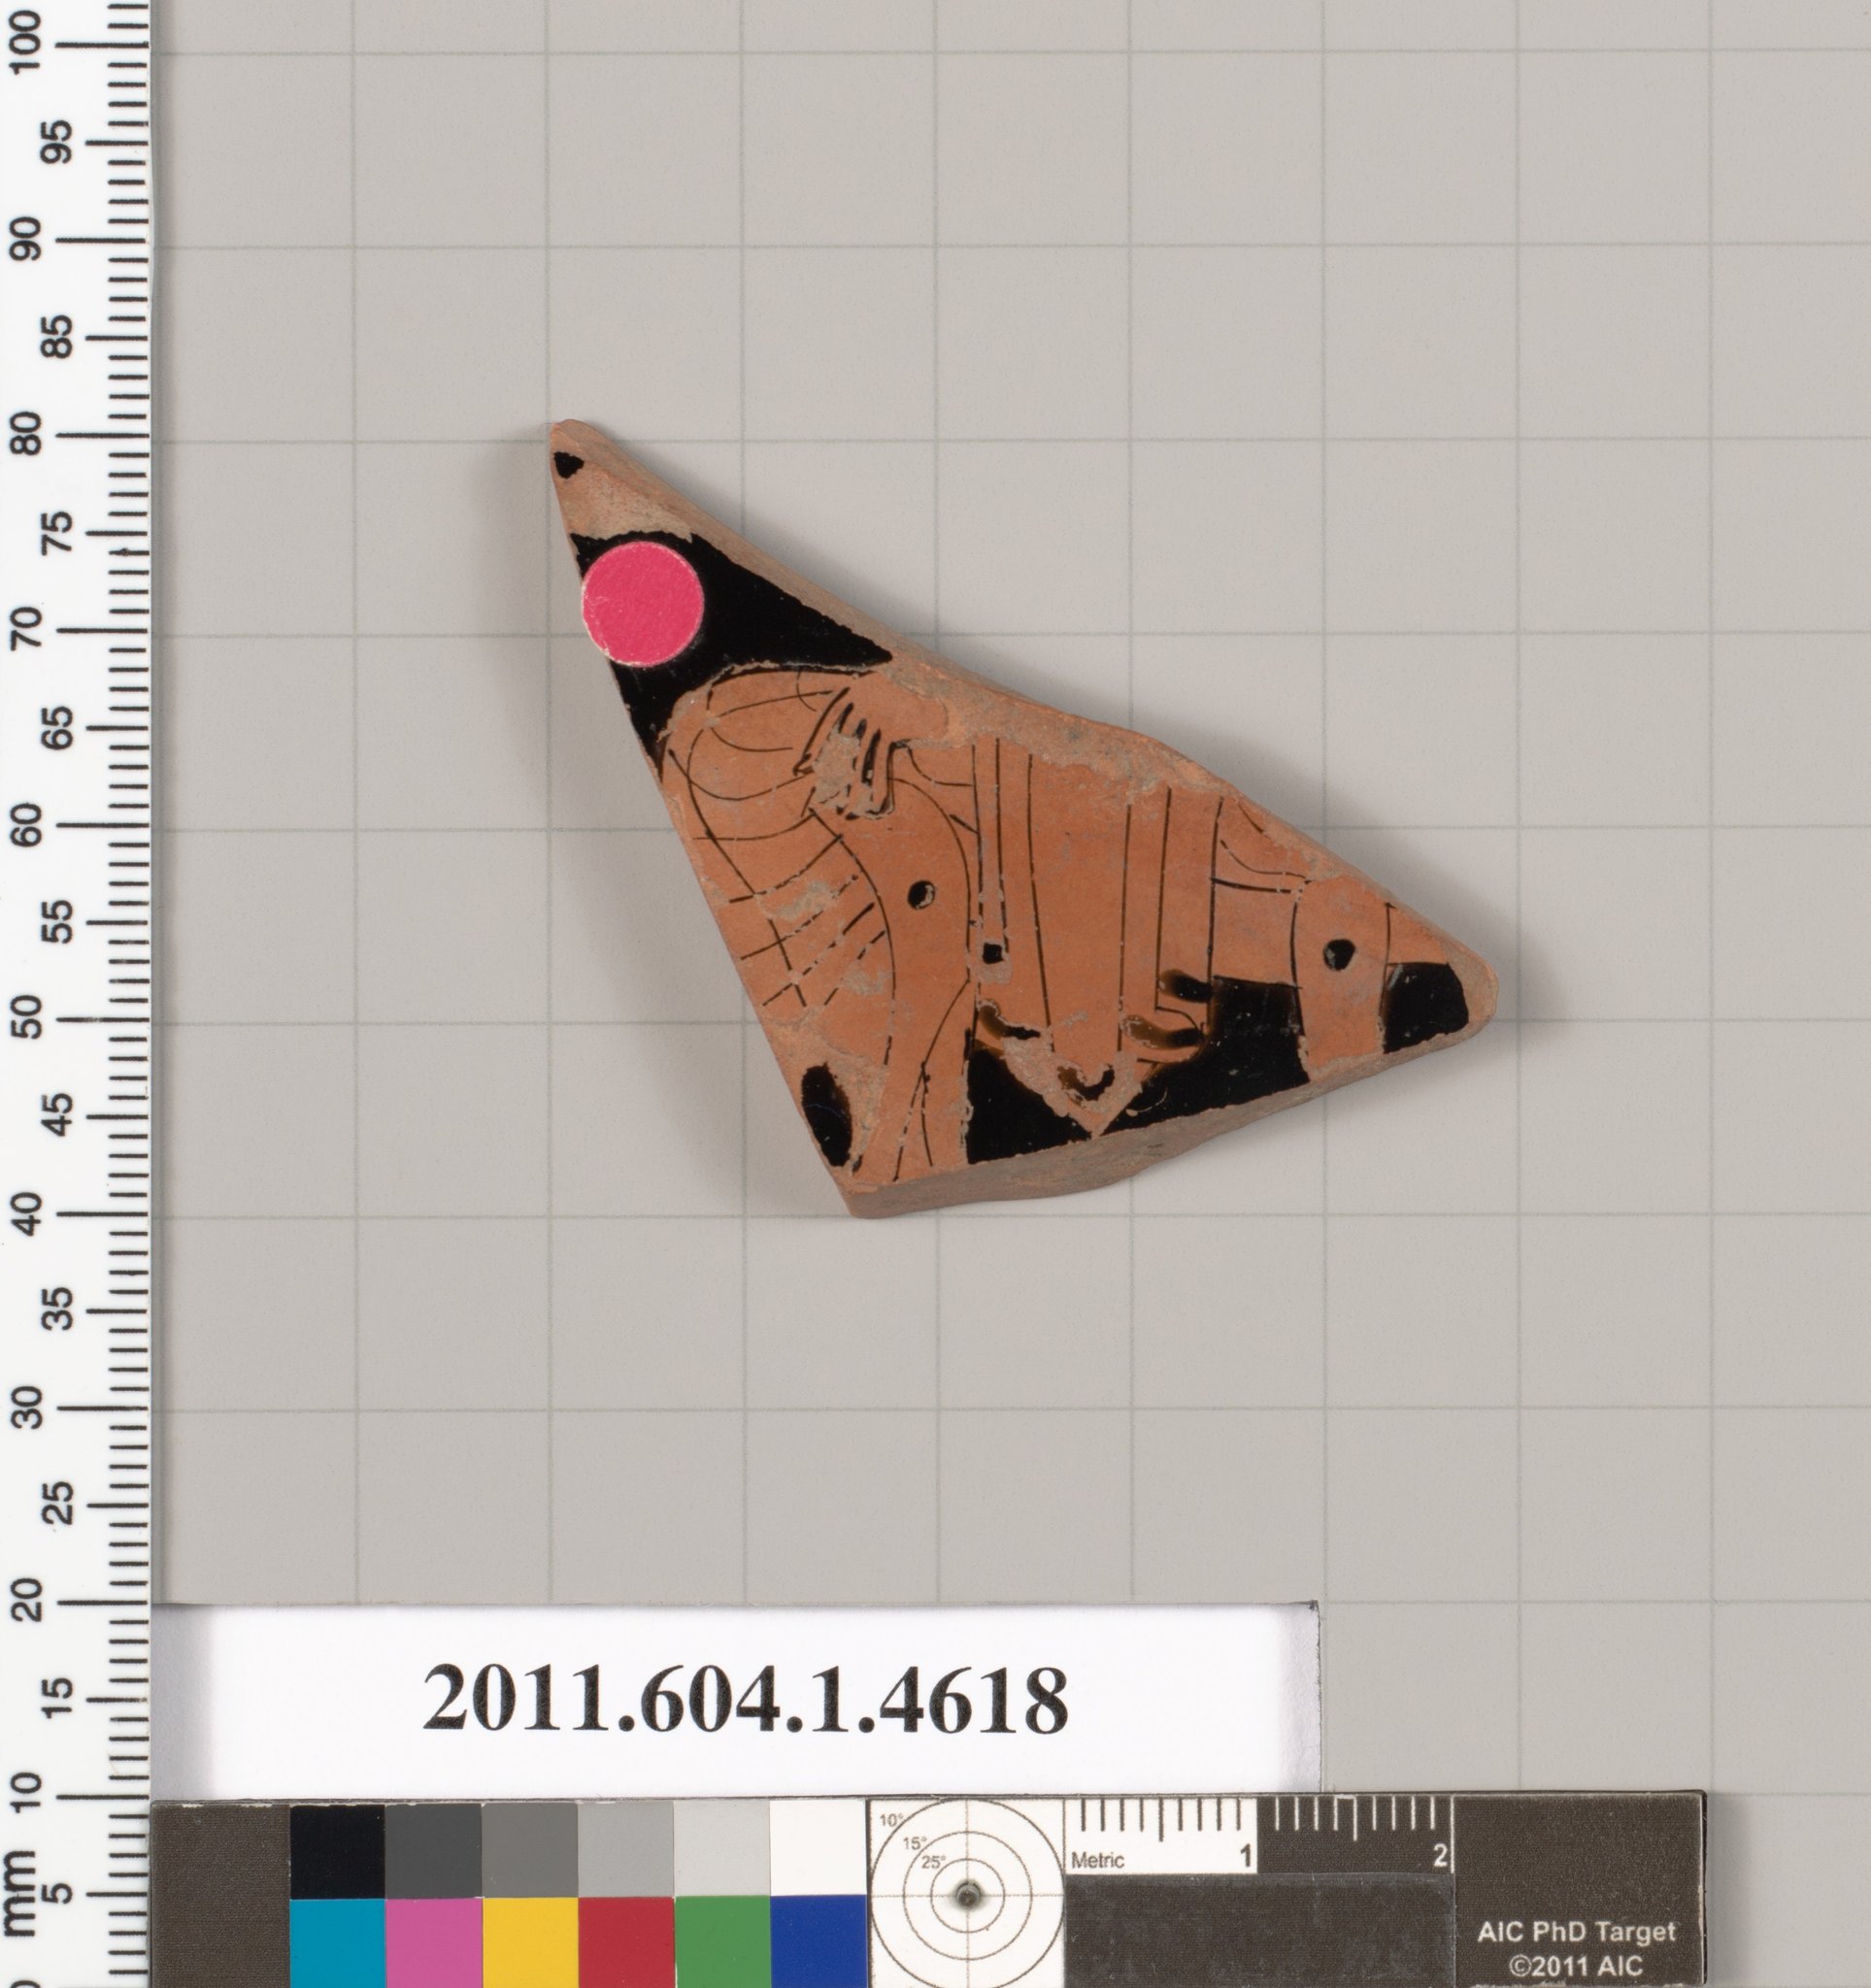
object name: kylix fragment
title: Terracotta fragment of a kylix (drinking cup)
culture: greek, attic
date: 500-470 BCE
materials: terracotta